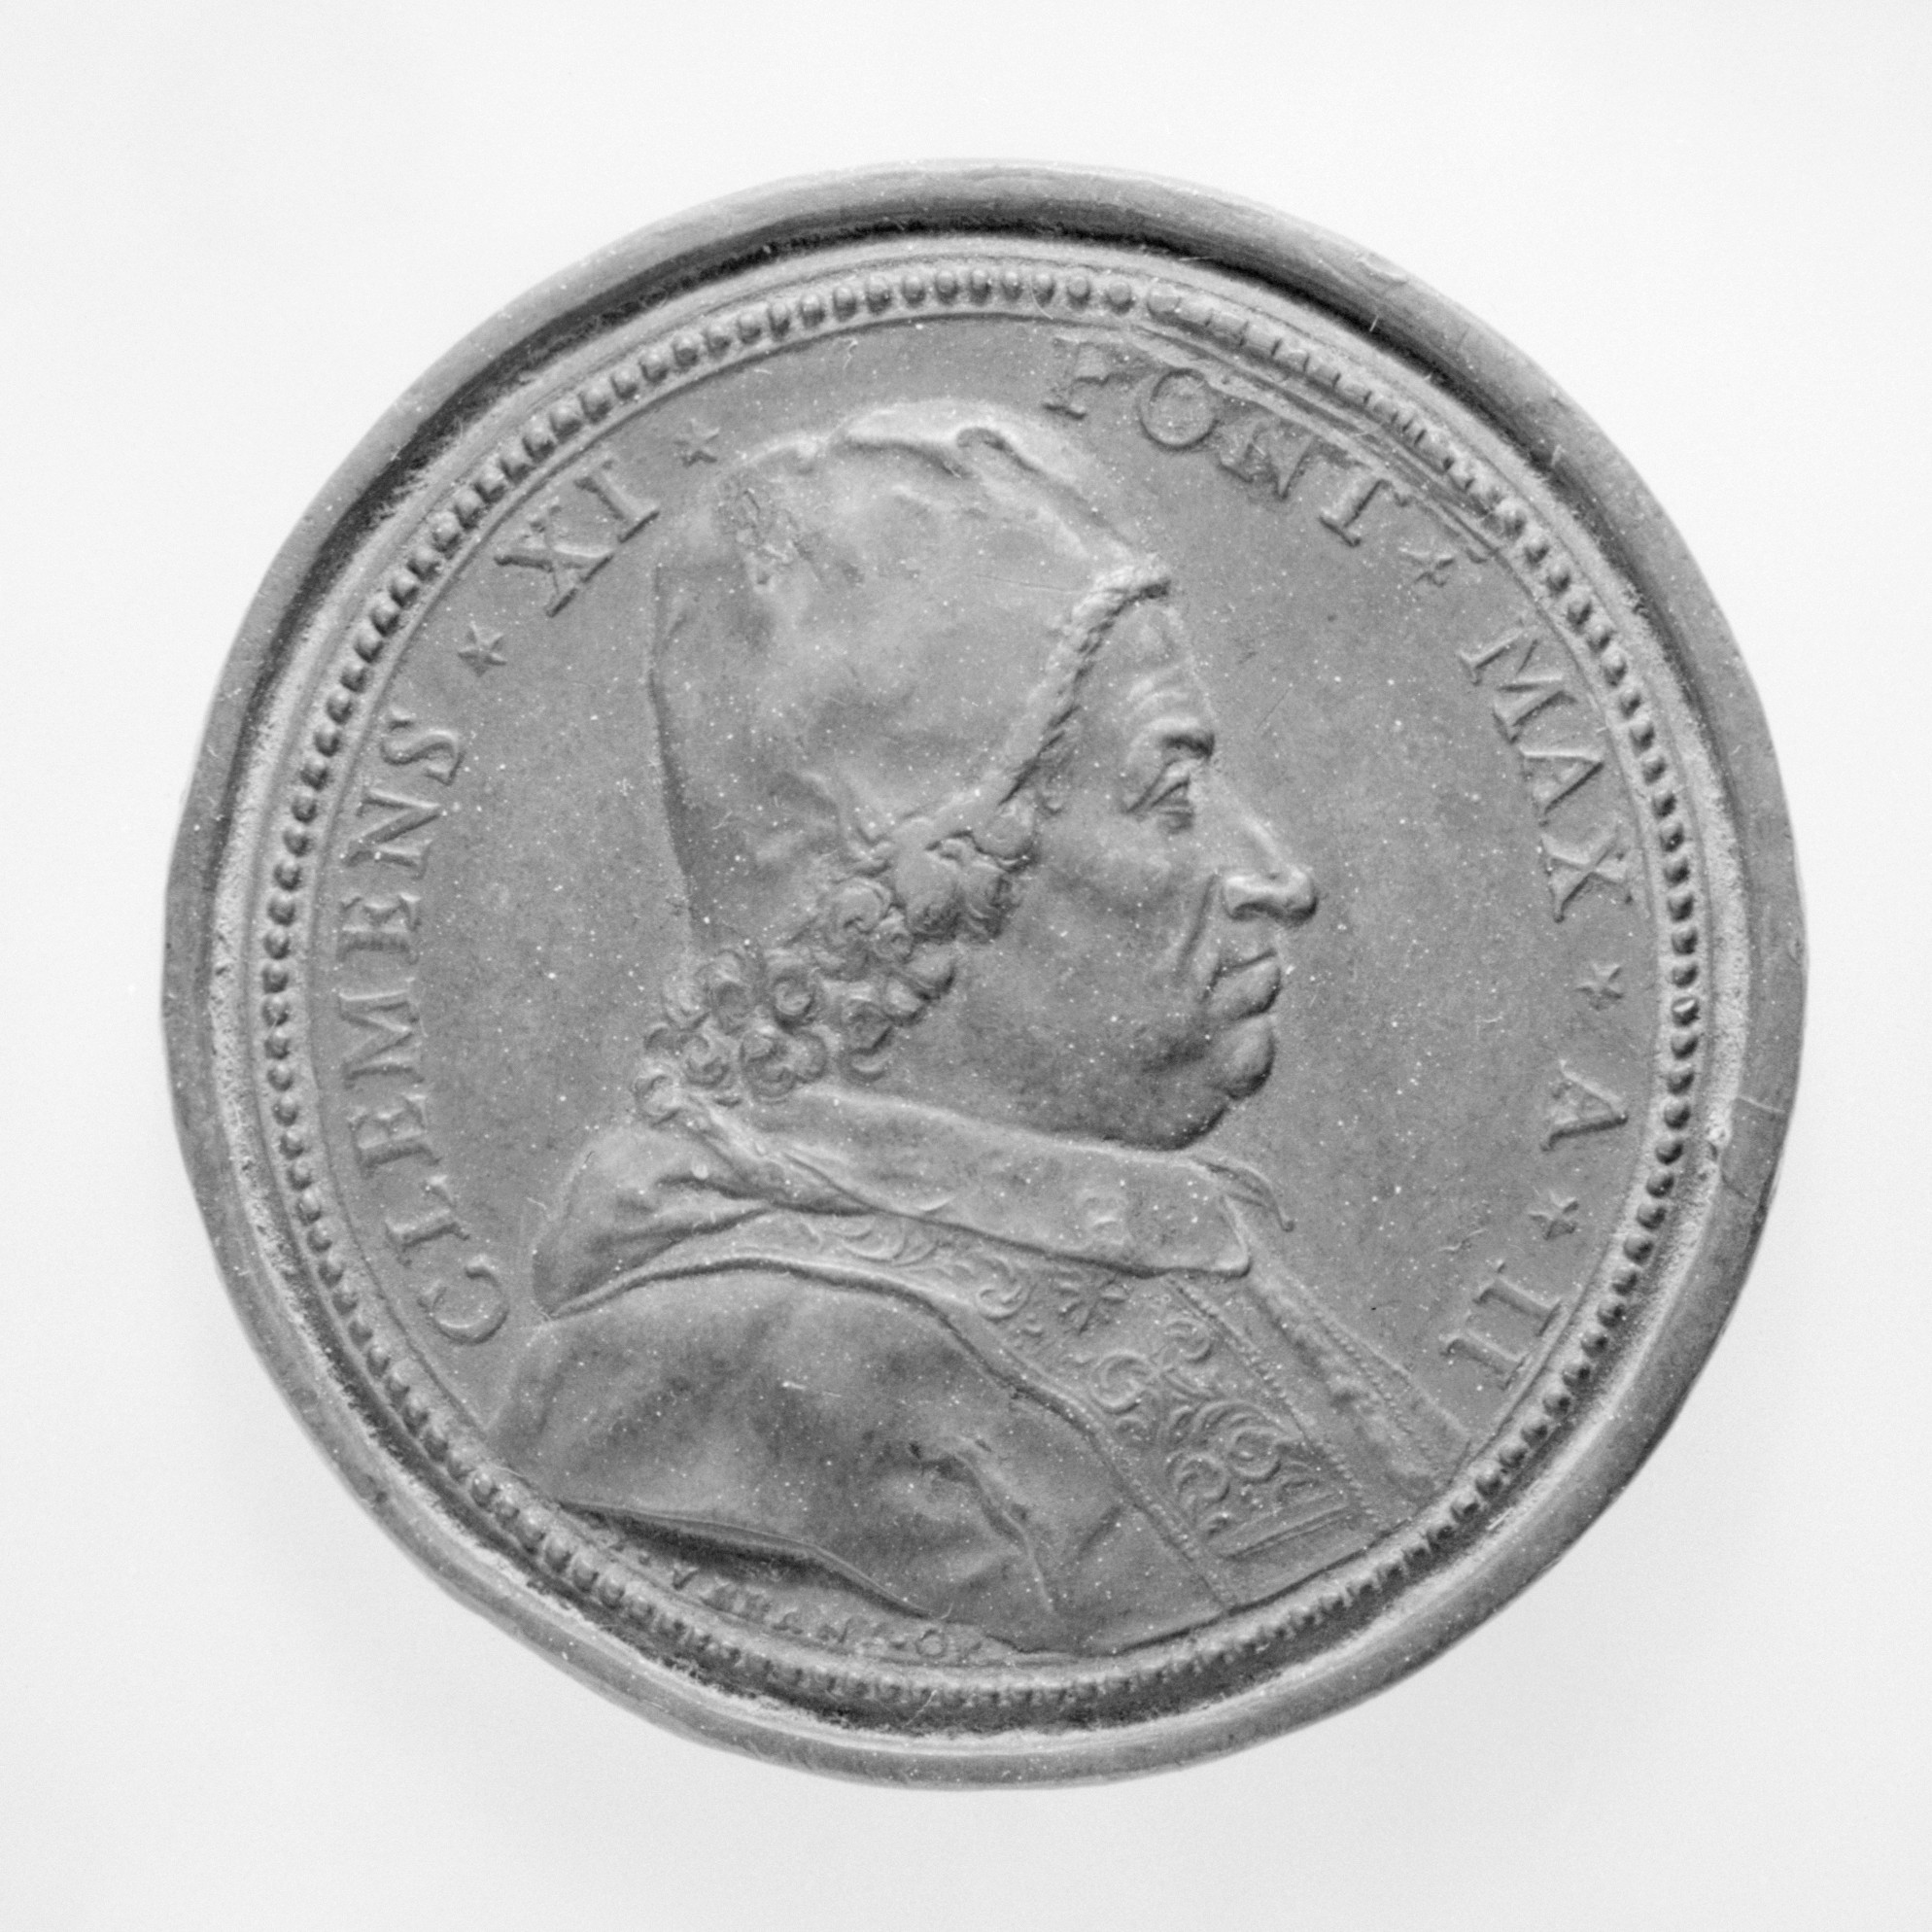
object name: medal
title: Clement XI (Pope 1700–21)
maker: ottone hamerani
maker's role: artist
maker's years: 1694-1768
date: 1701-1800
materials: bronze, patina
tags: profiles,popes